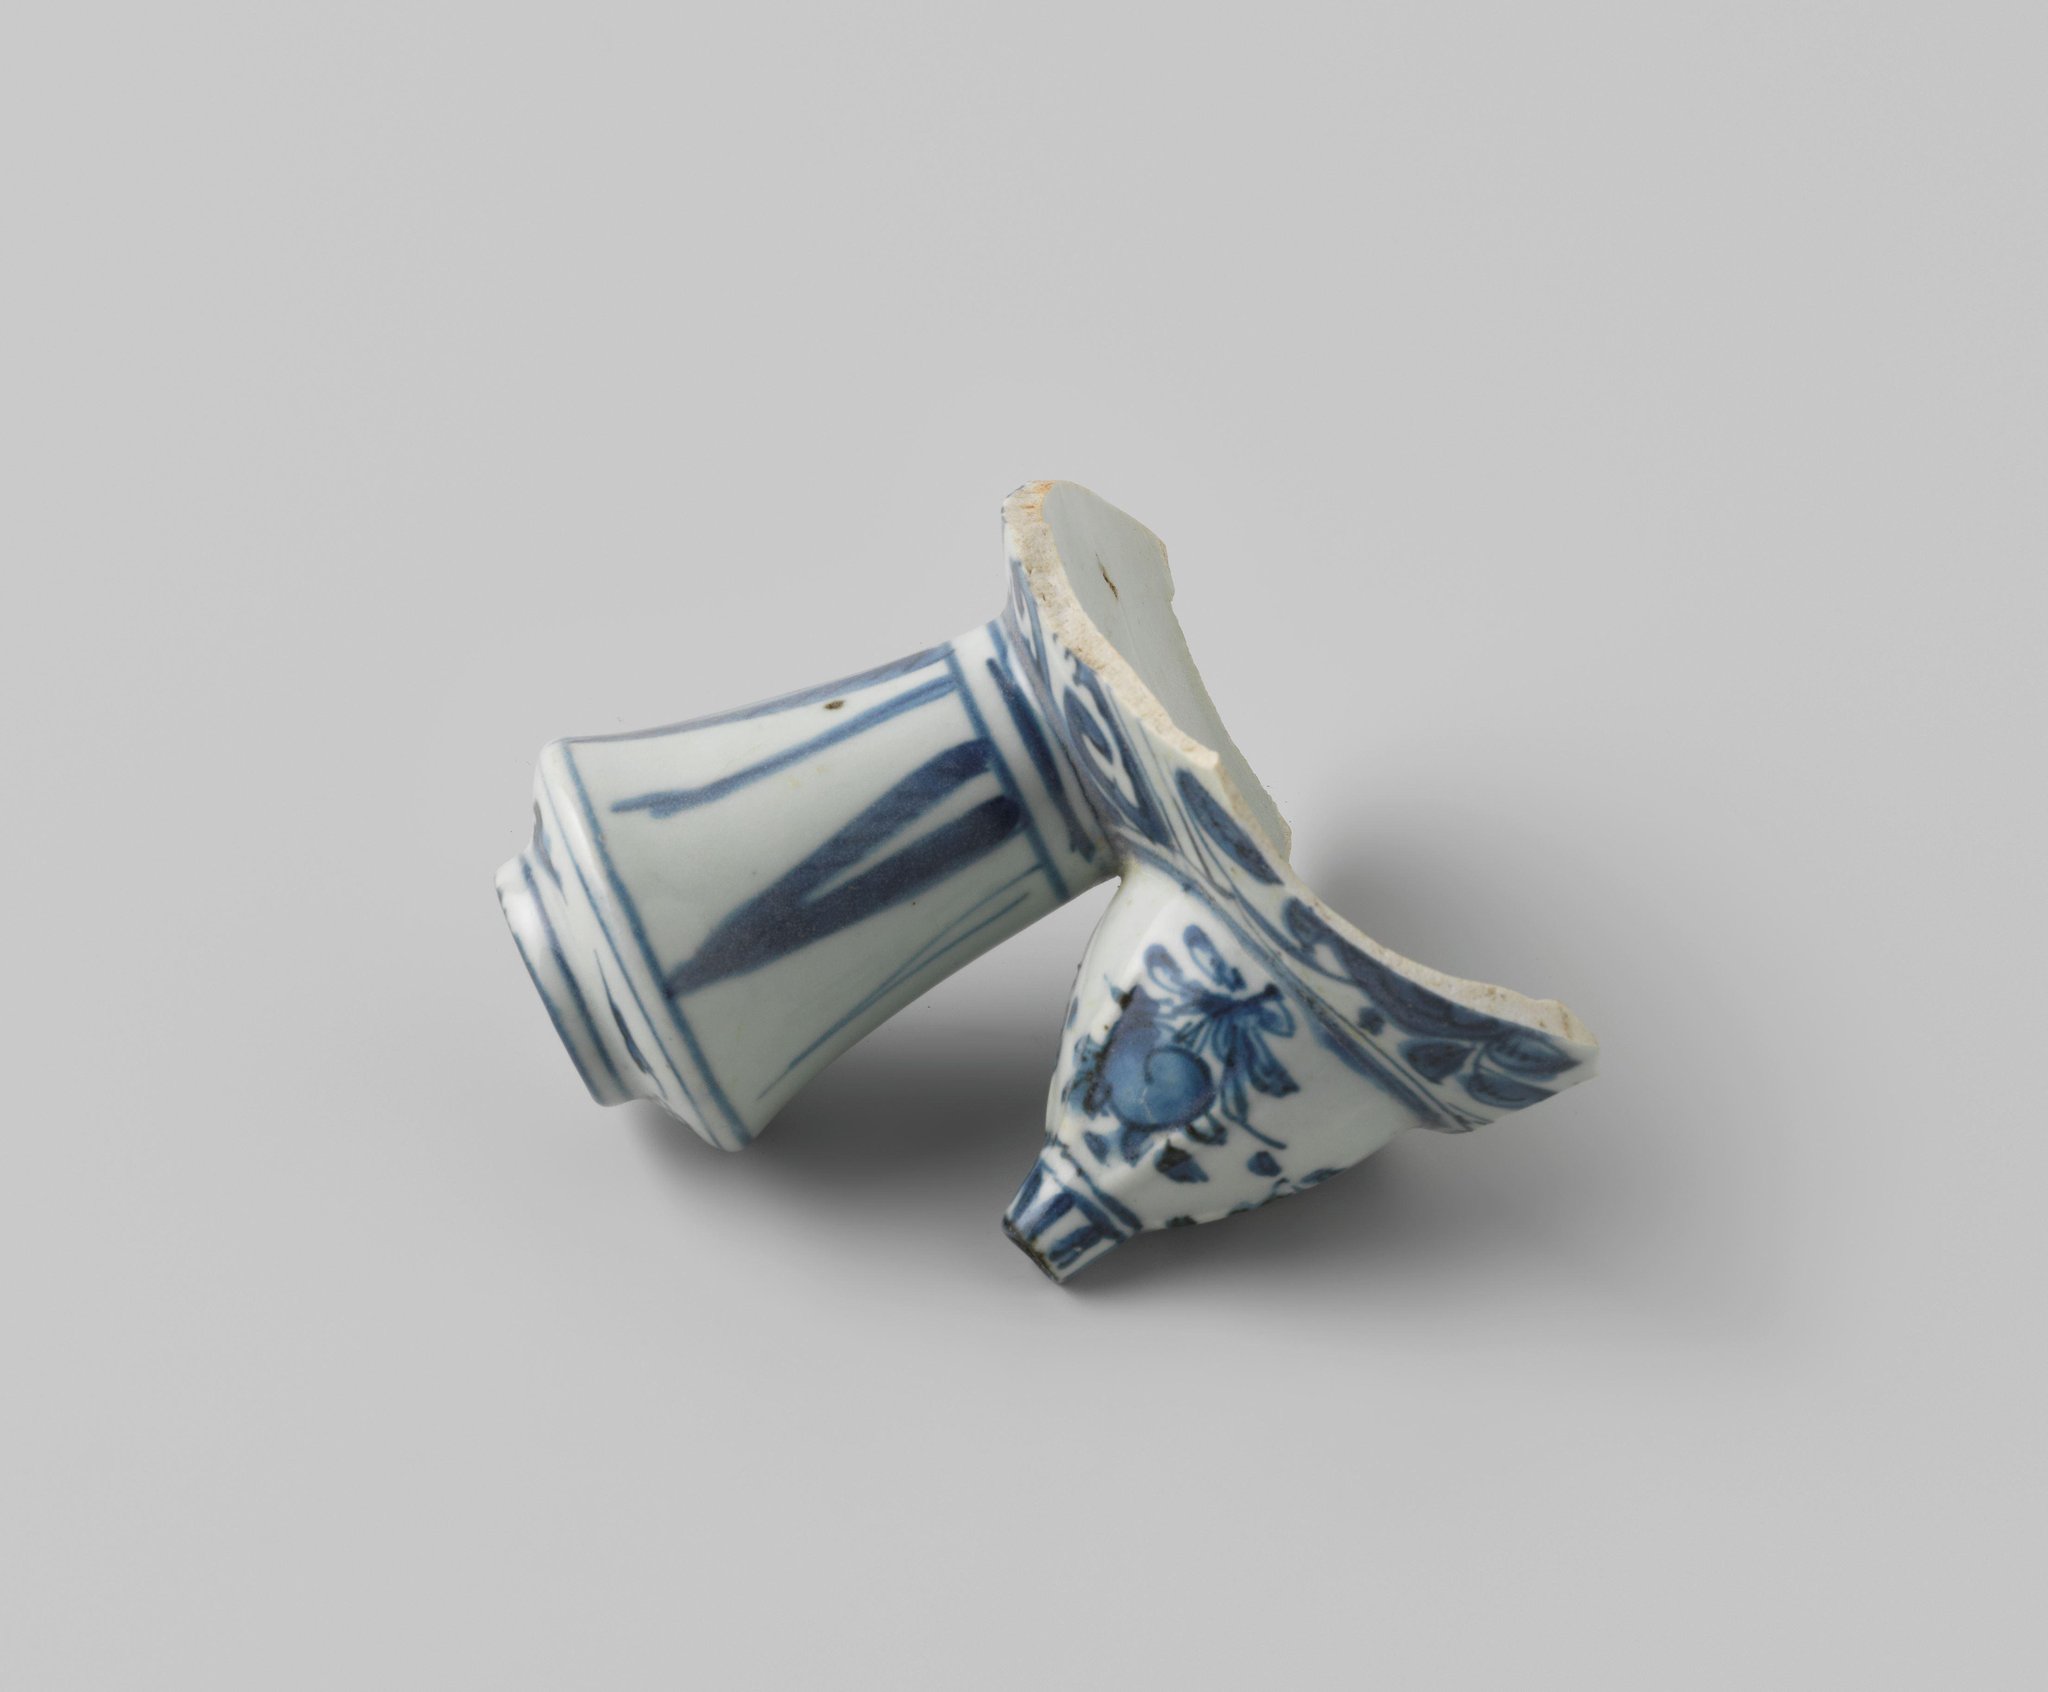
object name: wijnstoop, wijnkaraf, wijnkan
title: Fragment wijnkan uit V.O.C.-schip de 'Witte Leeuw'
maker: Anonymous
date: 1613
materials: bone china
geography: jingdezhen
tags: verenigde oostindische compagnie, sint-helena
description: A kendi with a rounded side. Decorated with birds and flowers under a band with diaper patterns. The neck decorated with plantain leaves, the spout with peaches and groups of dots in sections.